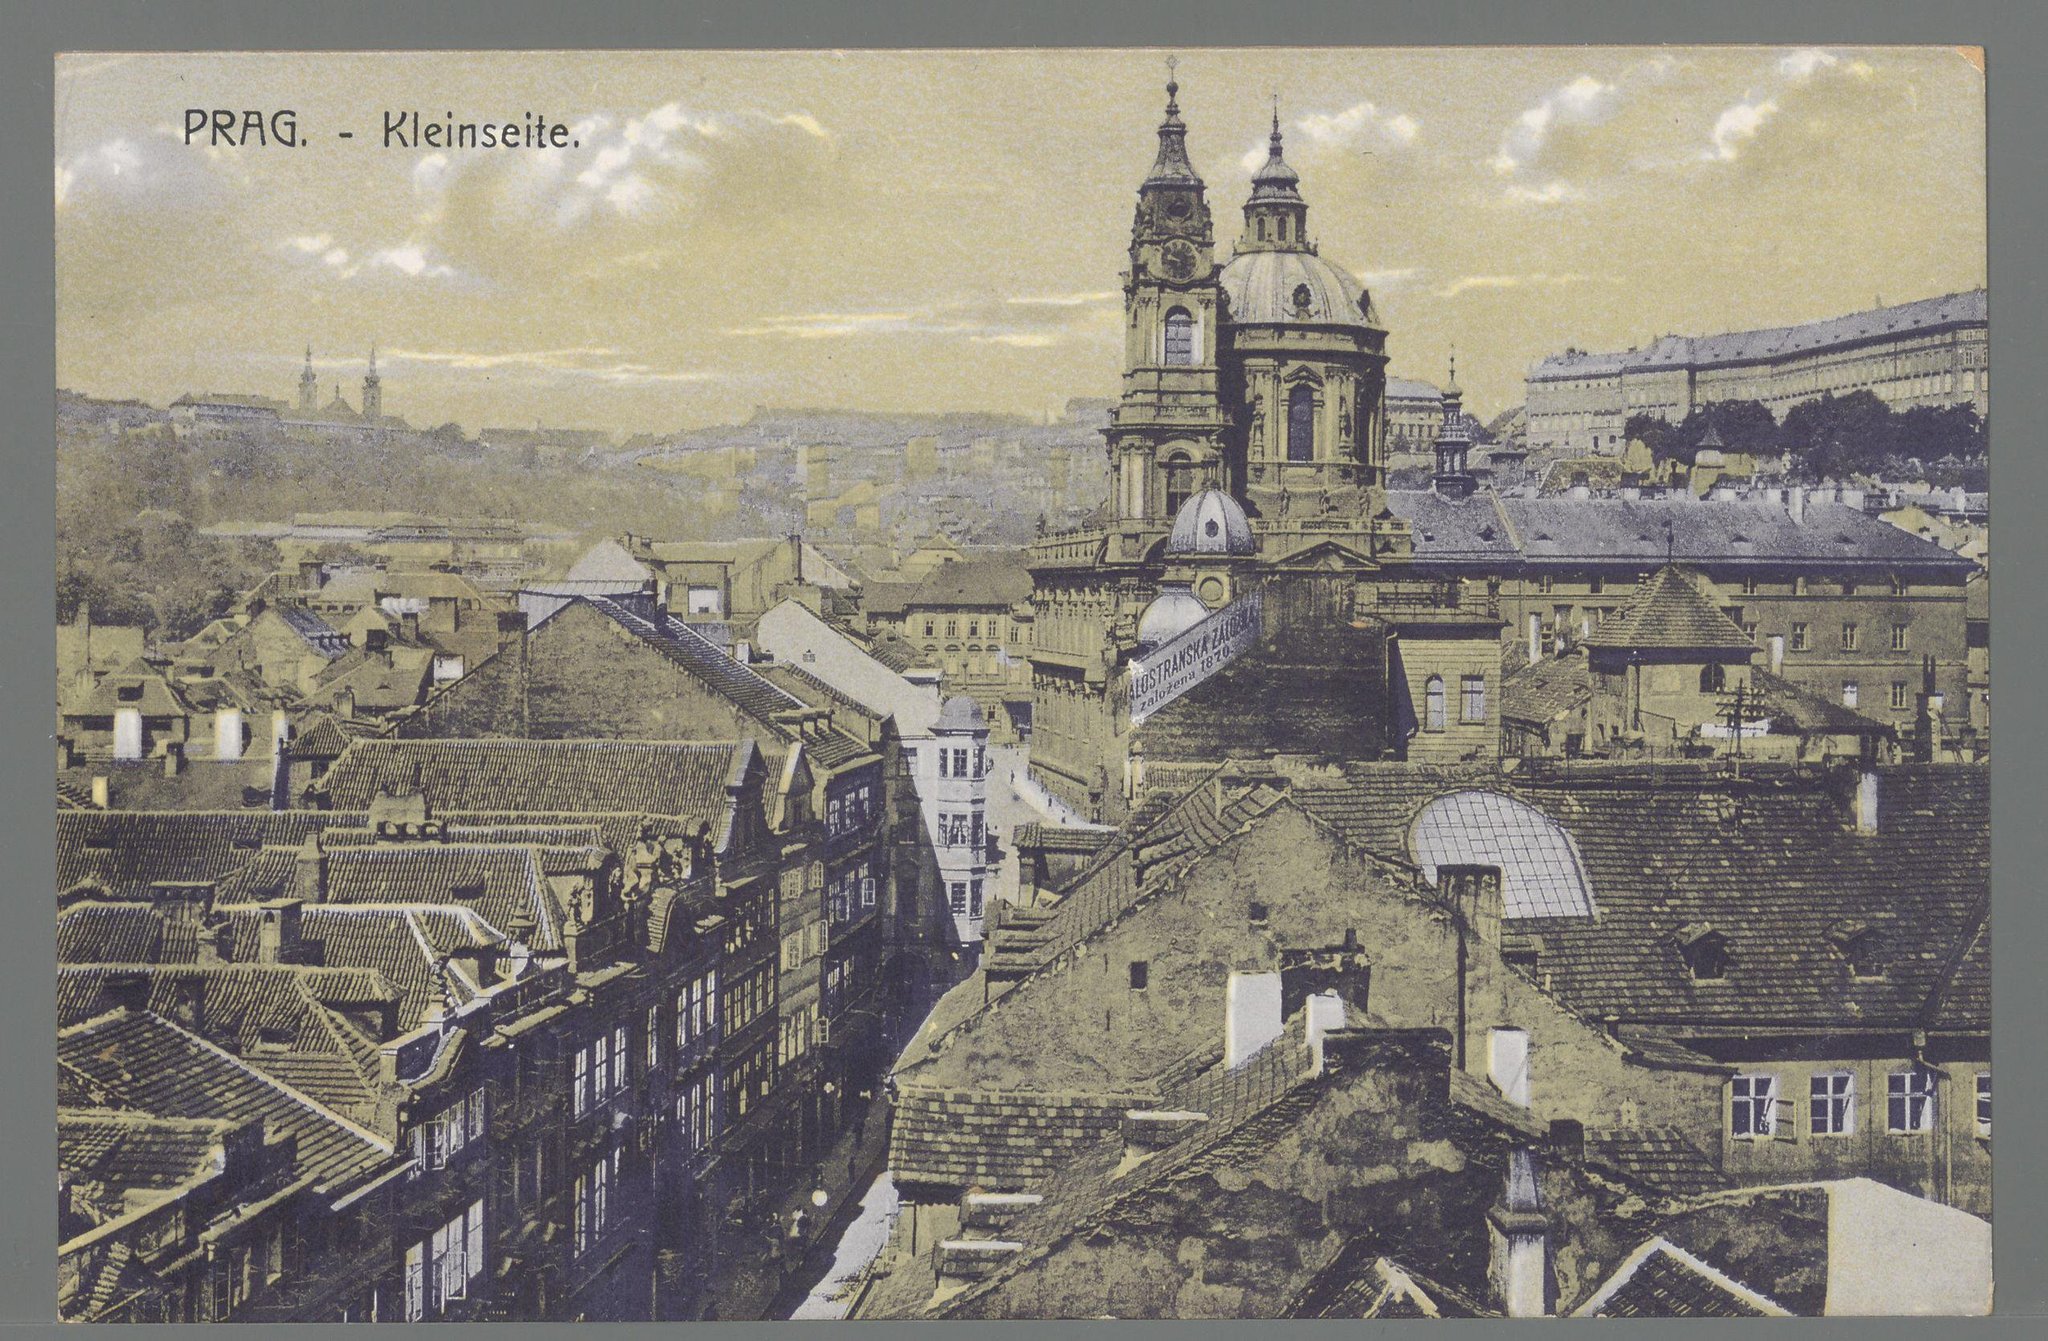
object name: ansichtkaart, prentbriefkaart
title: Prag - Kleinseite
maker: Anonymous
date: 1906-1920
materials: cardboard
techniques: photograph, lithograph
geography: prague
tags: city-view, and landscape with man-made constructions, church (exterior), street, prague